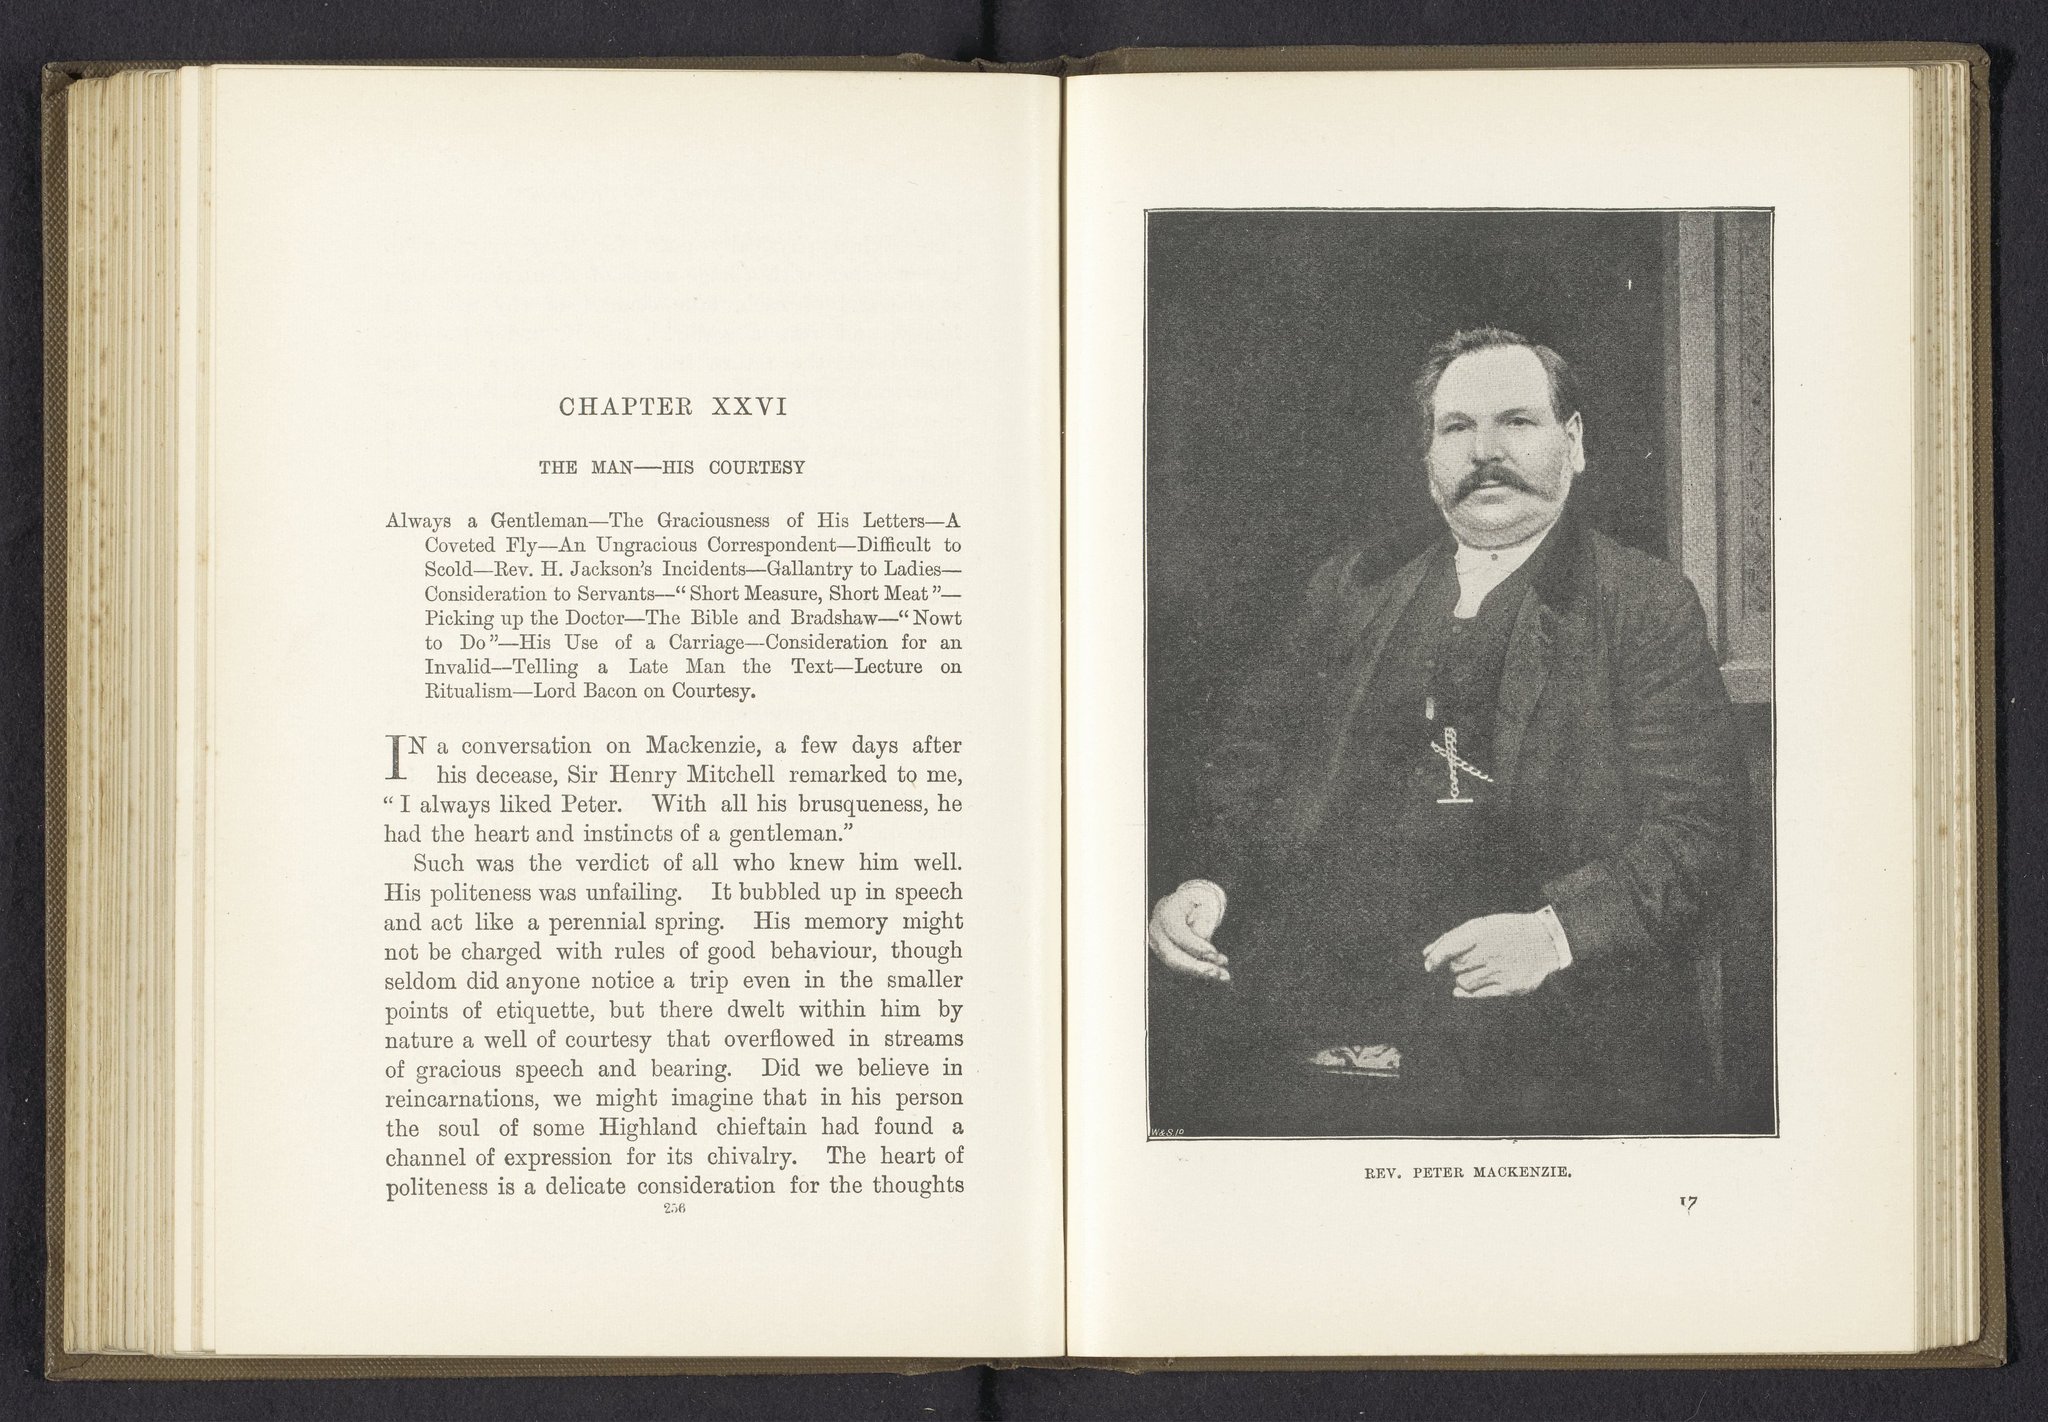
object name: page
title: Rev. Peter Mackenzie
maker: Anonymous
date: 1874-1884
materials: paper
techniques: autotype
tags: clergyman, historical persons